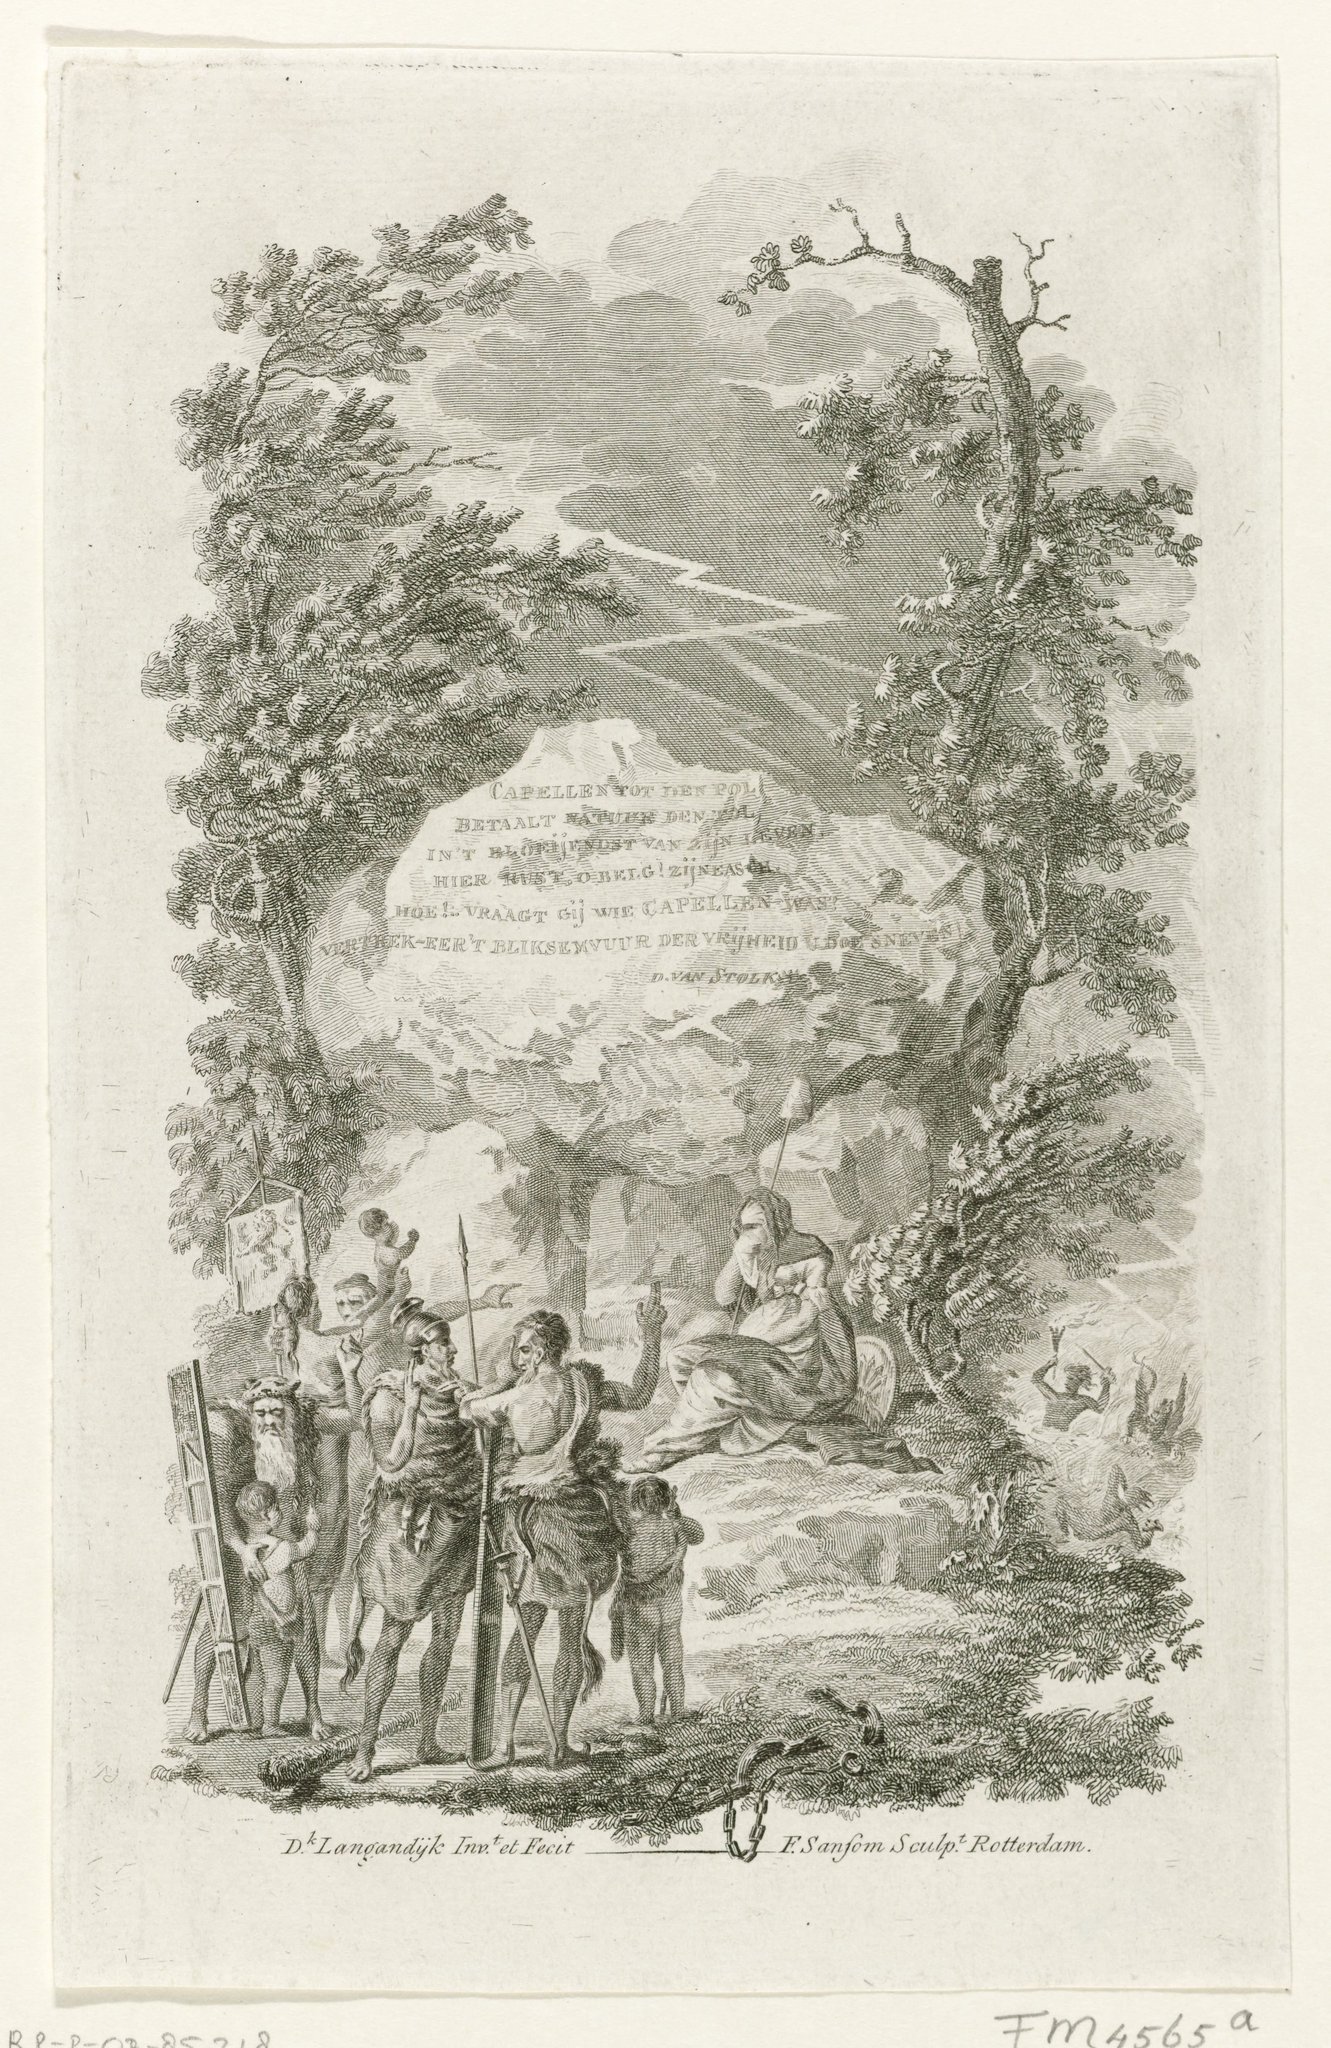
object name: print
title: Allegorie op de dood van Joan Derk van der Capellen tot den Pol, 1784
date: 1784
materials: paper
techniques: engraving, etching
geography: rotterdam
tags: politician, joan derk van der capellen tot den pol, megalithic chambered tomb, dolmen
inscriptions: collector's mark: Lugt 2228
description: Allegorie op het overlijden van Joan Derk van der Capellen tot den Pol, 6 juni 1784. Een groep Bataven wijst naar een vers op de overledene op de deksteen van een hunebed. Onder de rots zit de treurende Nederlandse Maagd. Vanuit de wolken bliksemschichten.